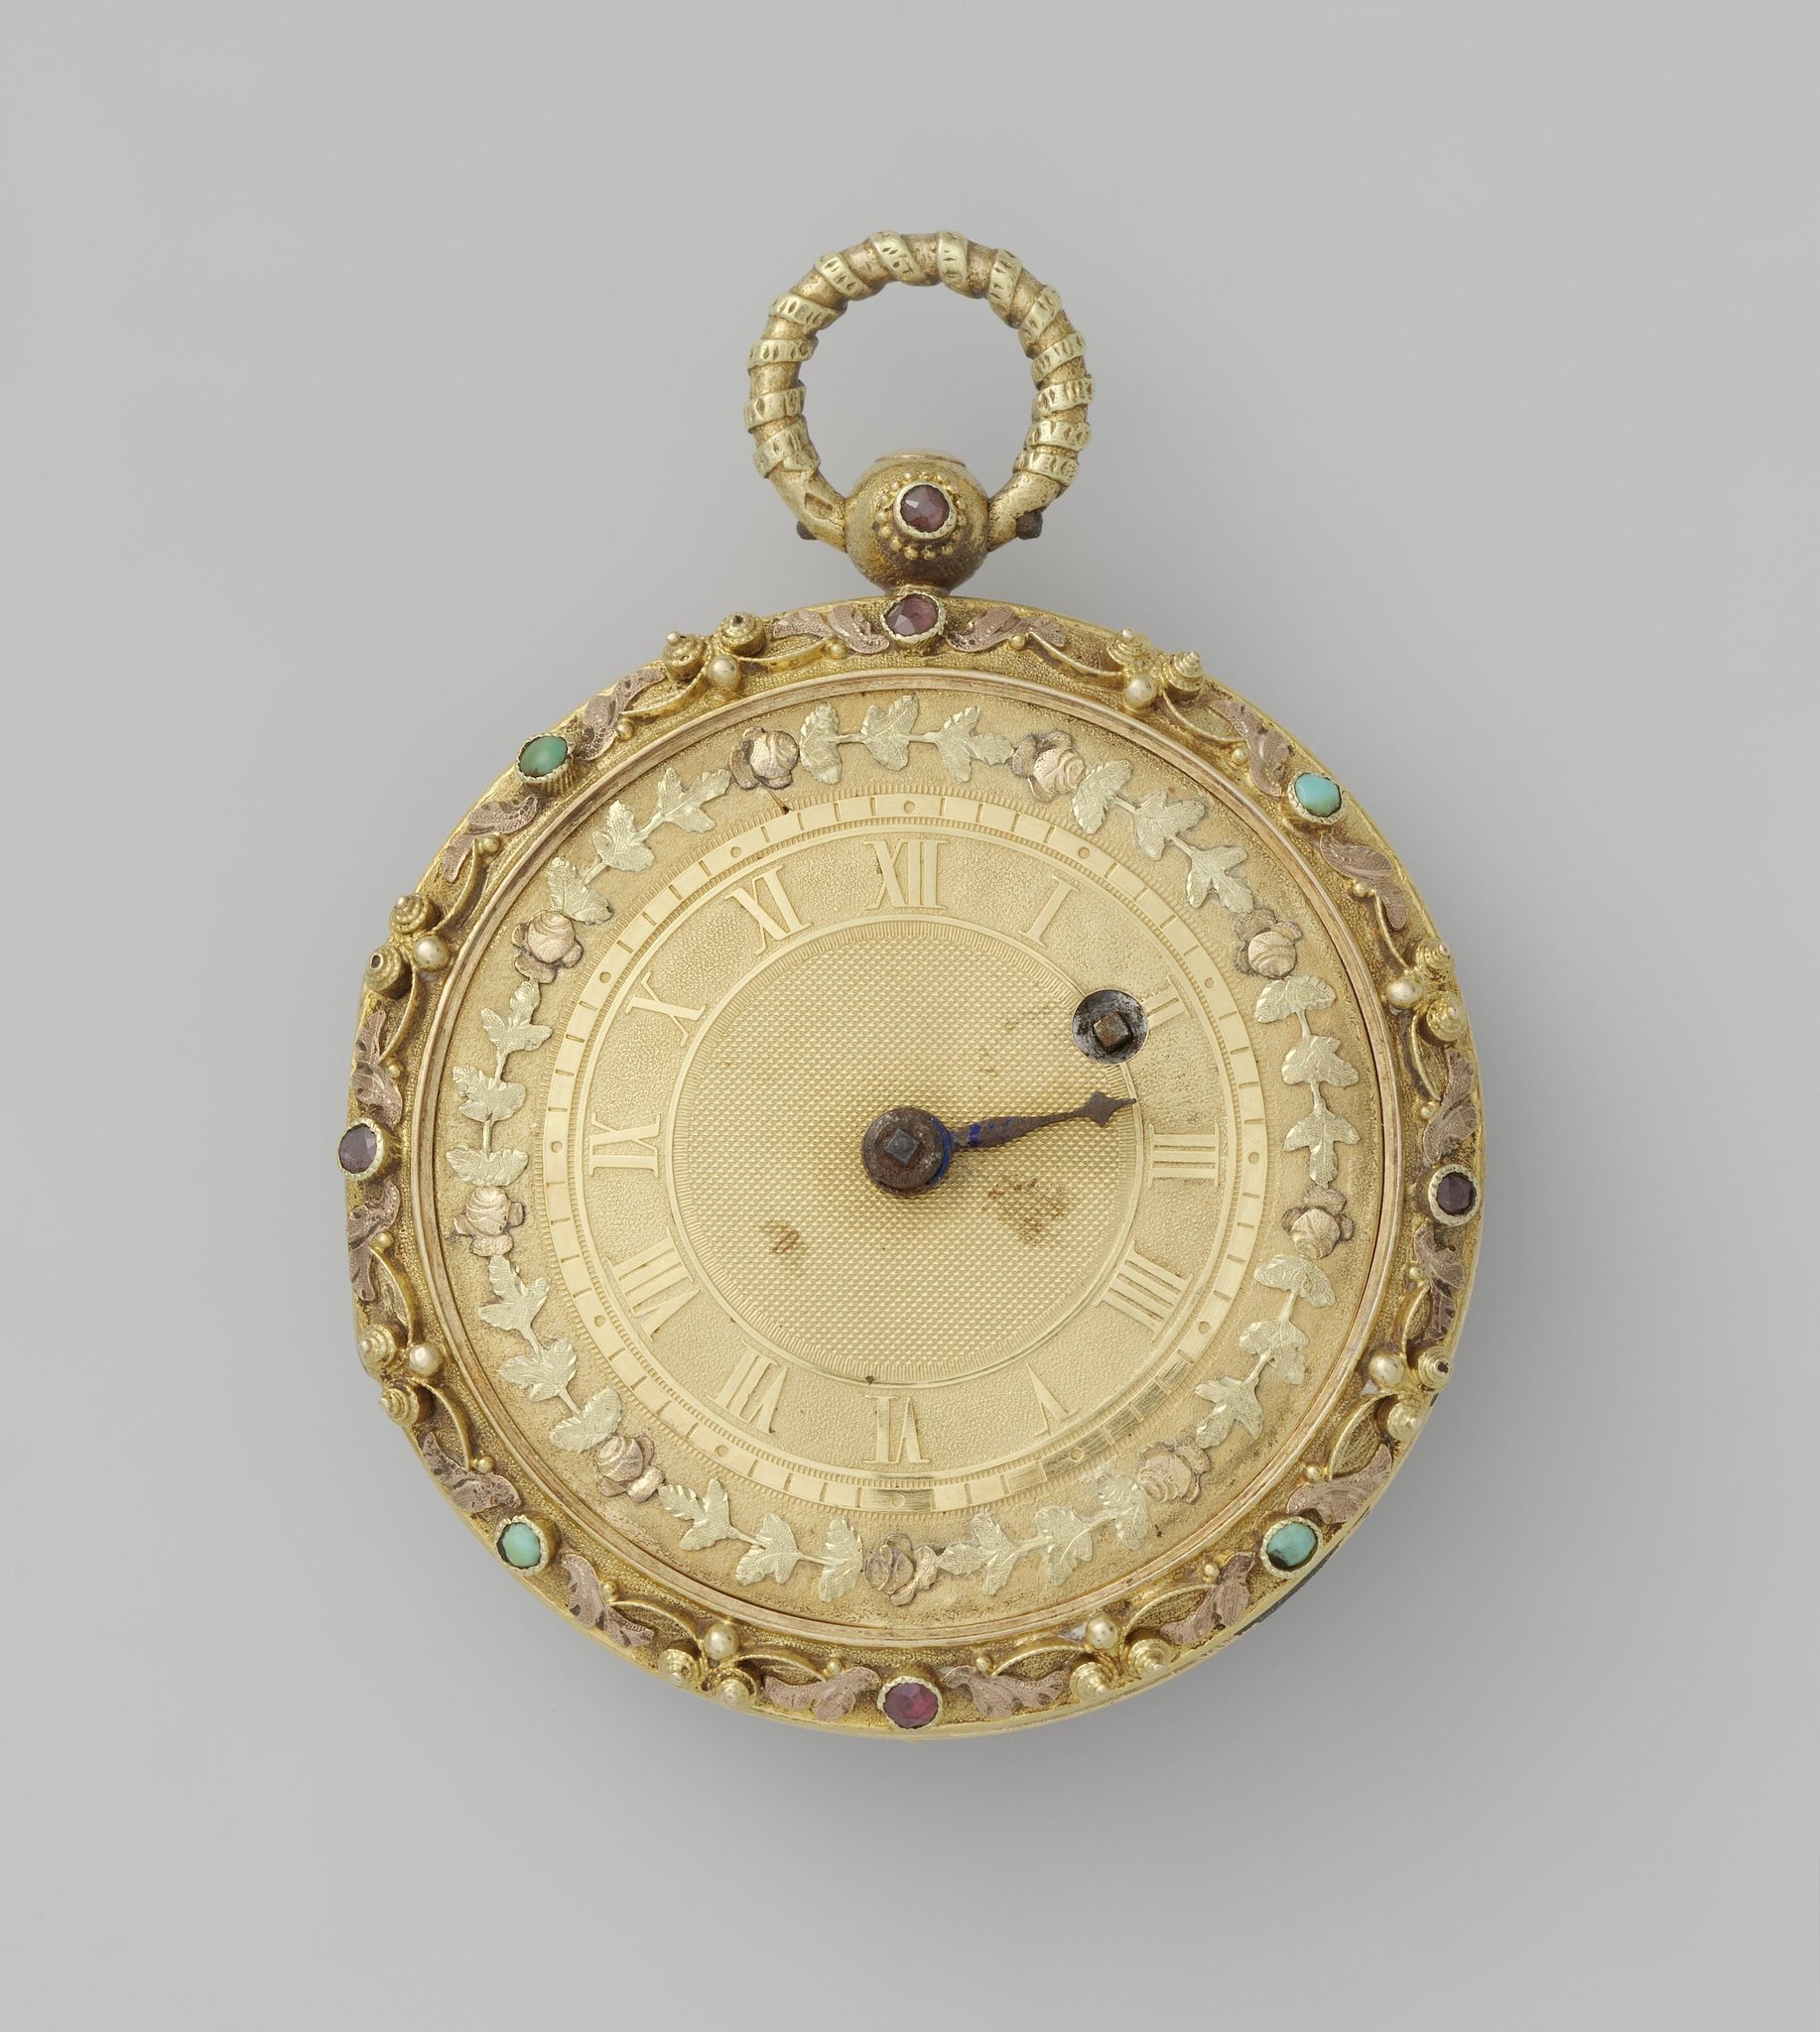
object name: jewellery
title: Watch with Flowers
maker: Anonymous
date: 1850-1860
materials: gold, opal, gemstone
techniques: filigree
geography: geneva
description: Horloge van goud. Versierd met filigrein ornament en robijnen en opalen.